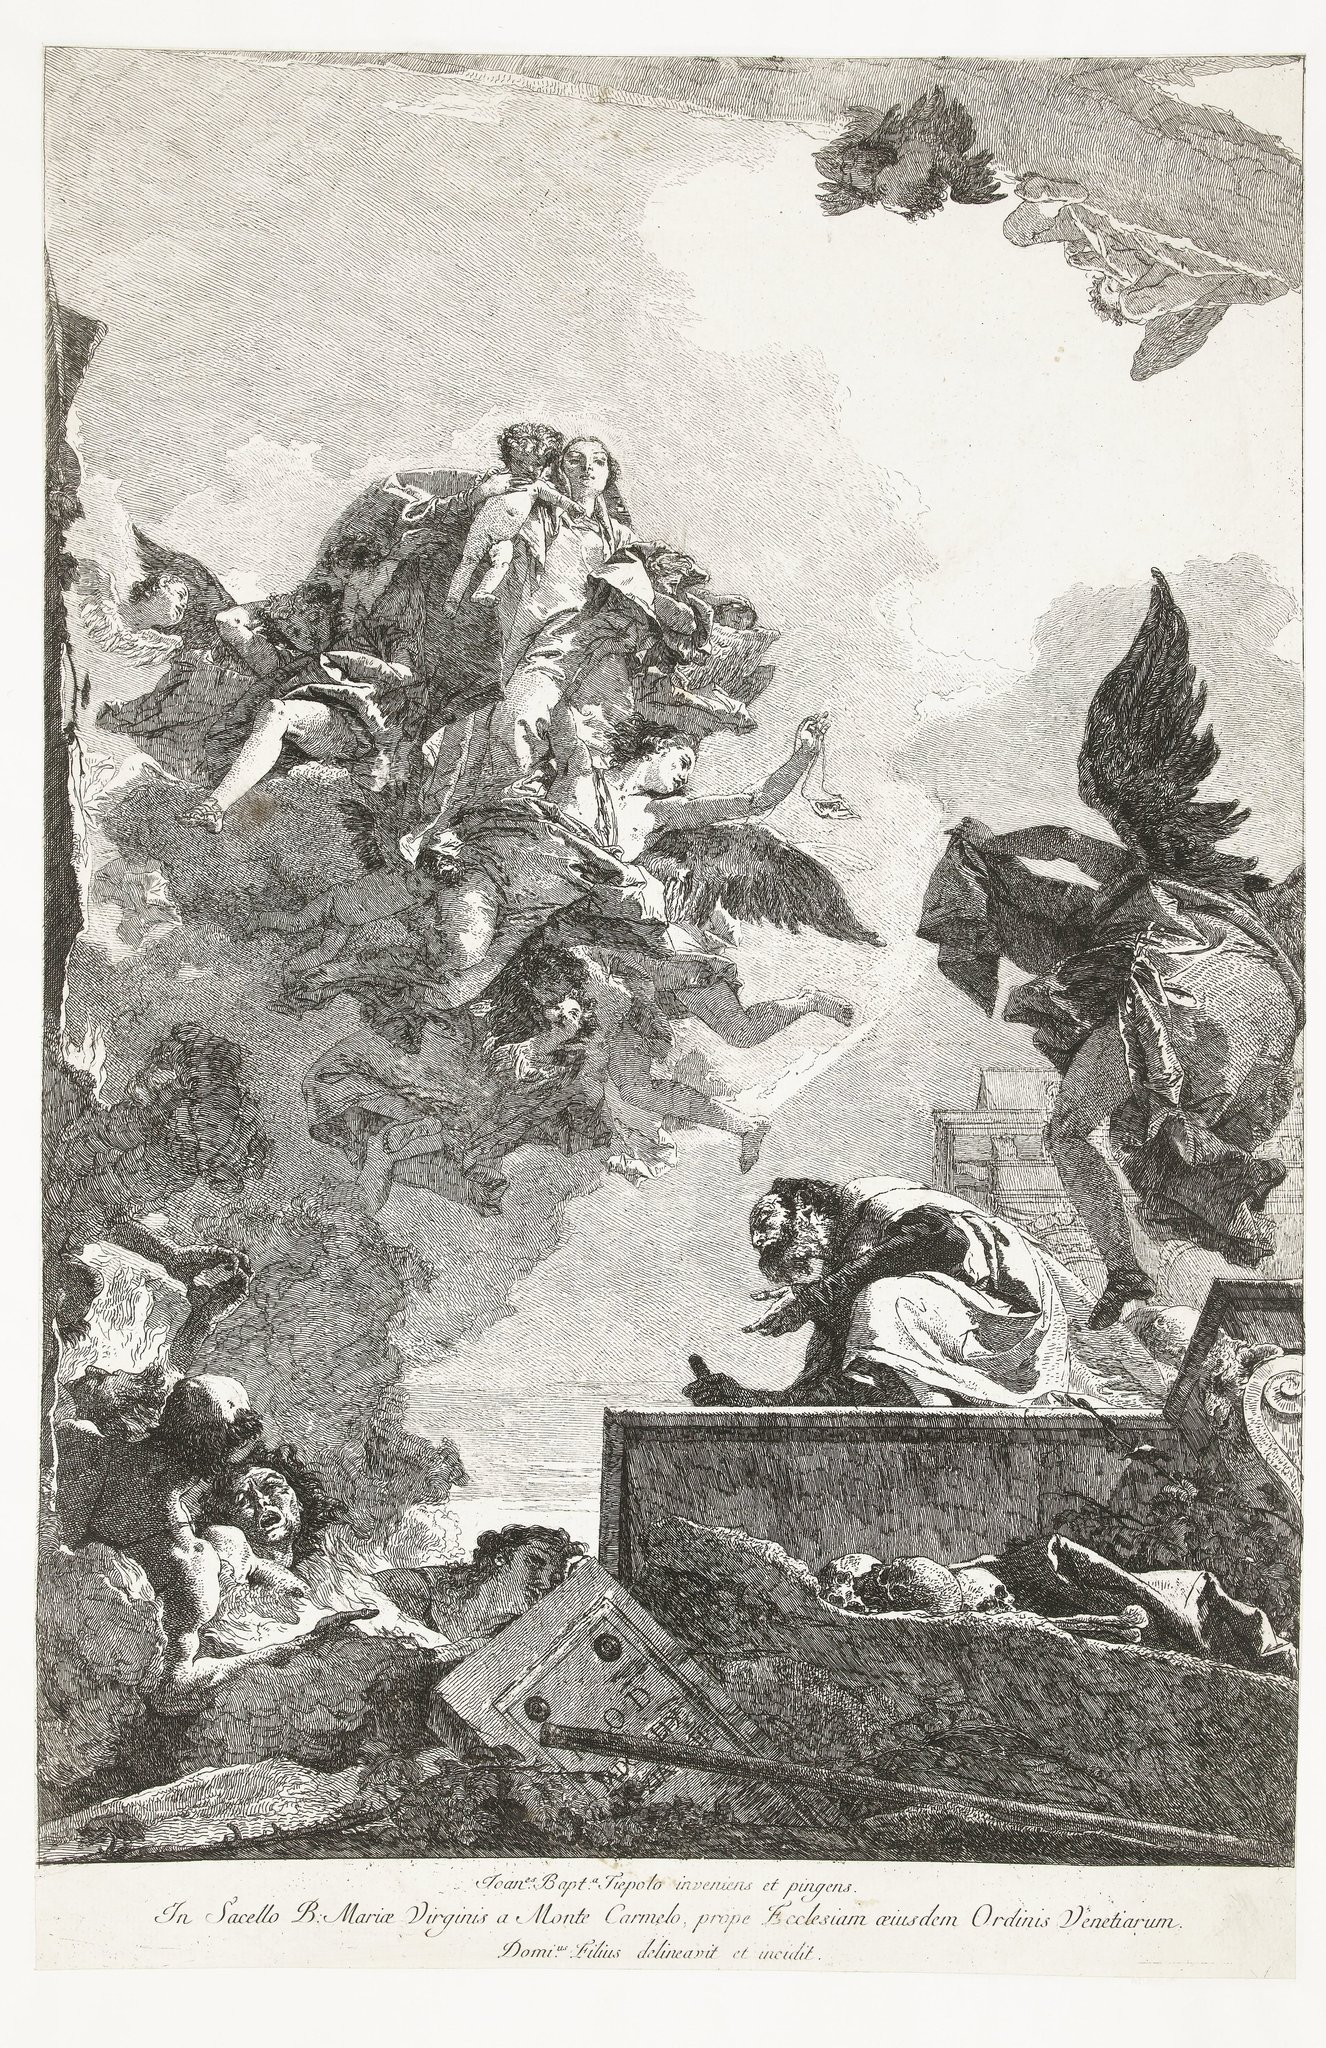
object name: print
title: Maria verschijnt aan heilige Simon Stock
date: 1749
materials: paper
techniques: etching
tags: the carmelite friar simon stock; possible attributes: scapular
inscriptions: collector's mark: Lugt 2228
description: Prent naar fresco in Scuola dei Carmini te Venetië door Giovanni Battista Tiepolo.